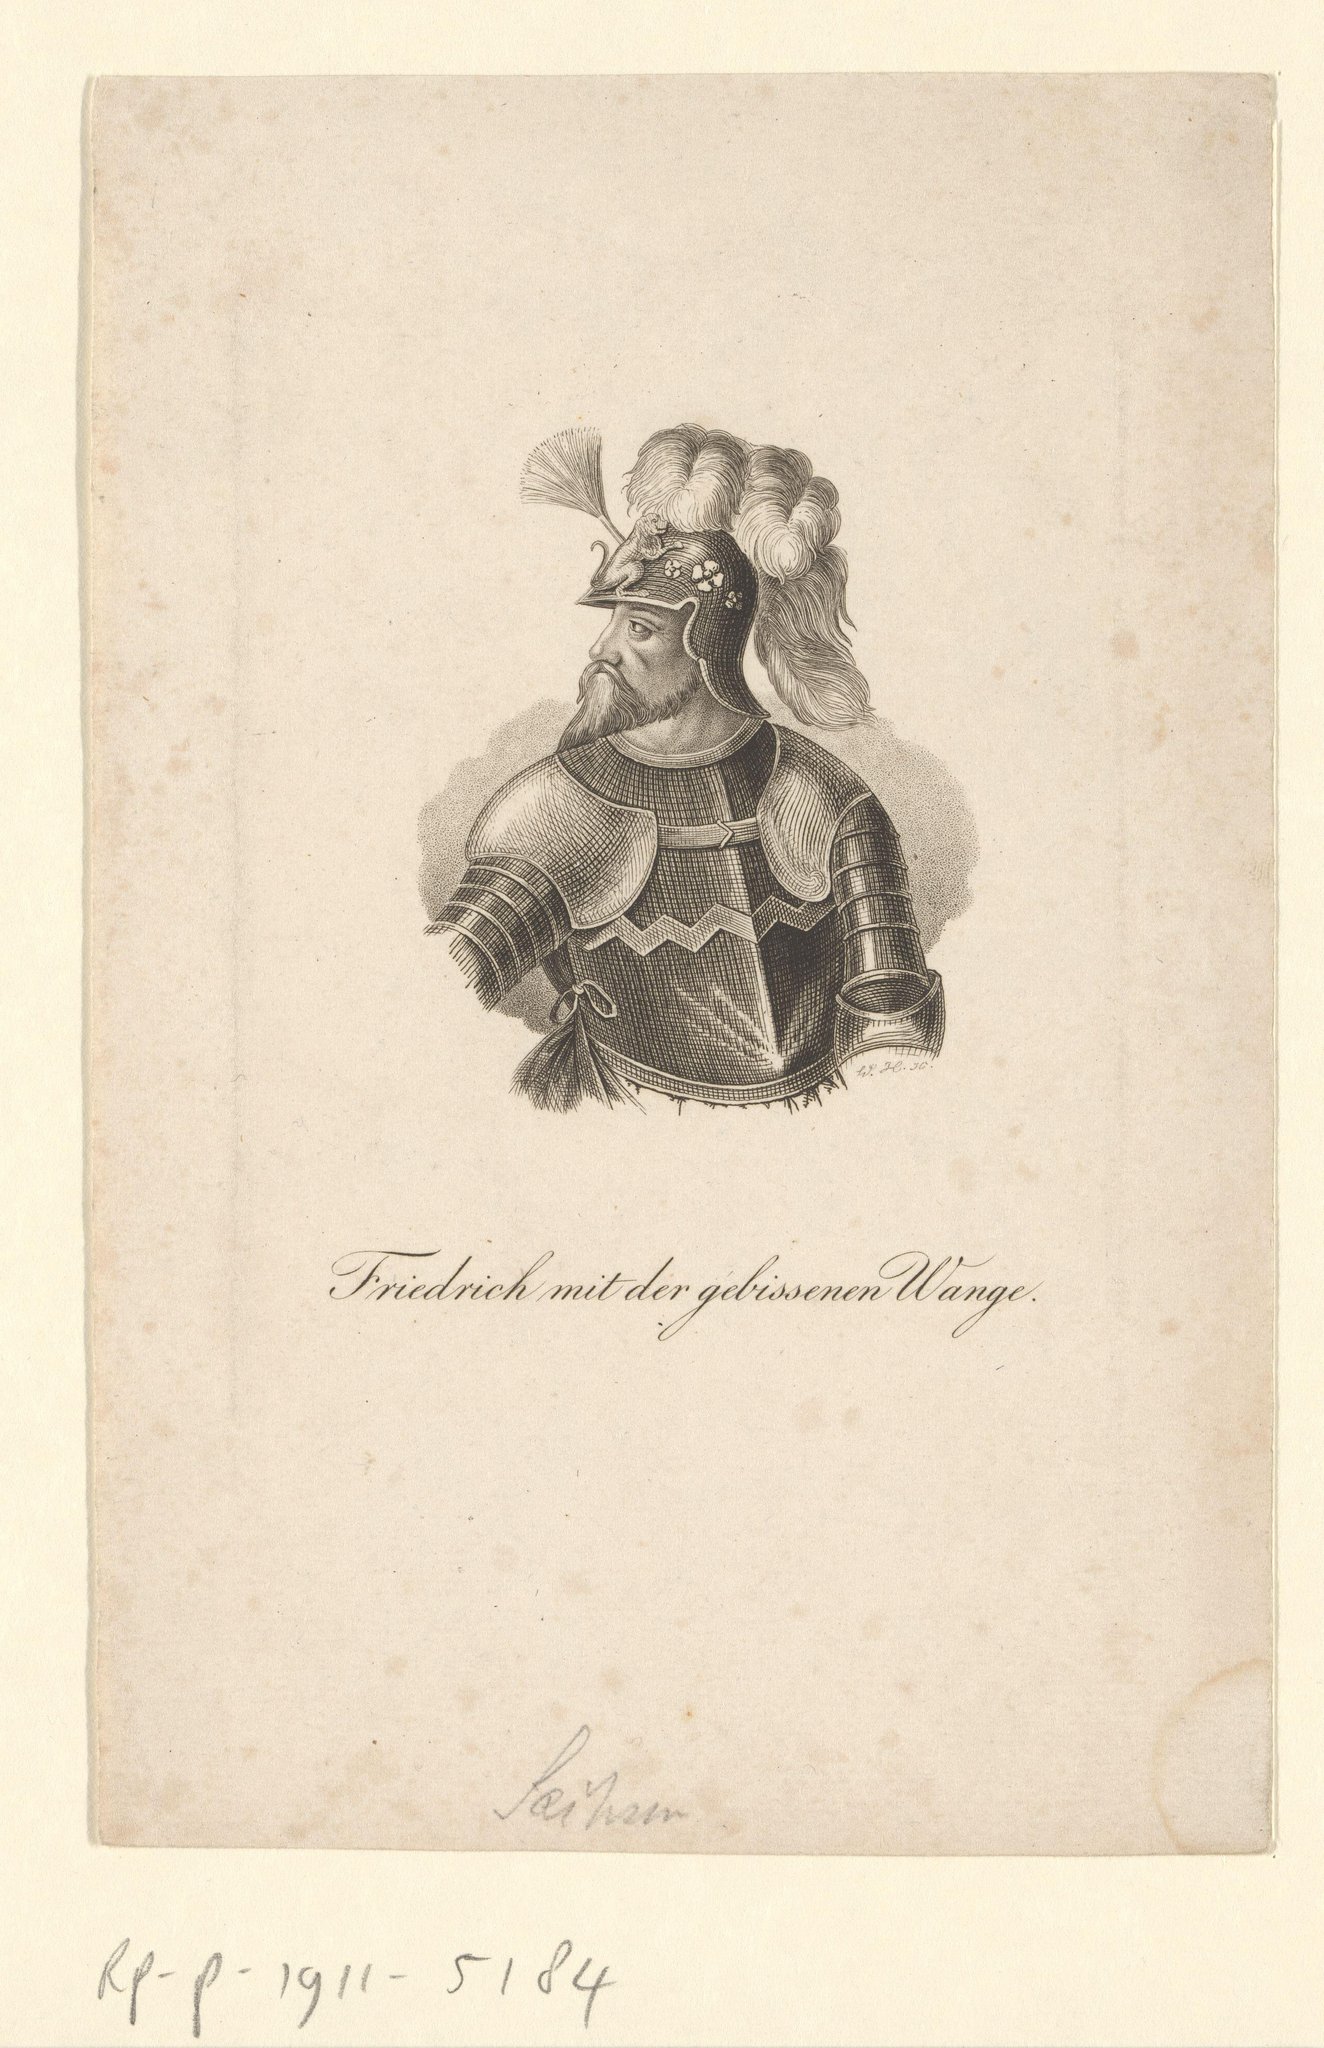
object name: print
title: Portret van Frederik I van Meissen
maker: monogrammist wh (duitsland)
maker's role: print maker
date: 1750-1849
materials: paper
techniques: engraving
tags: armour, historical persons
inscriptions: collector's mark: Lugt 2228